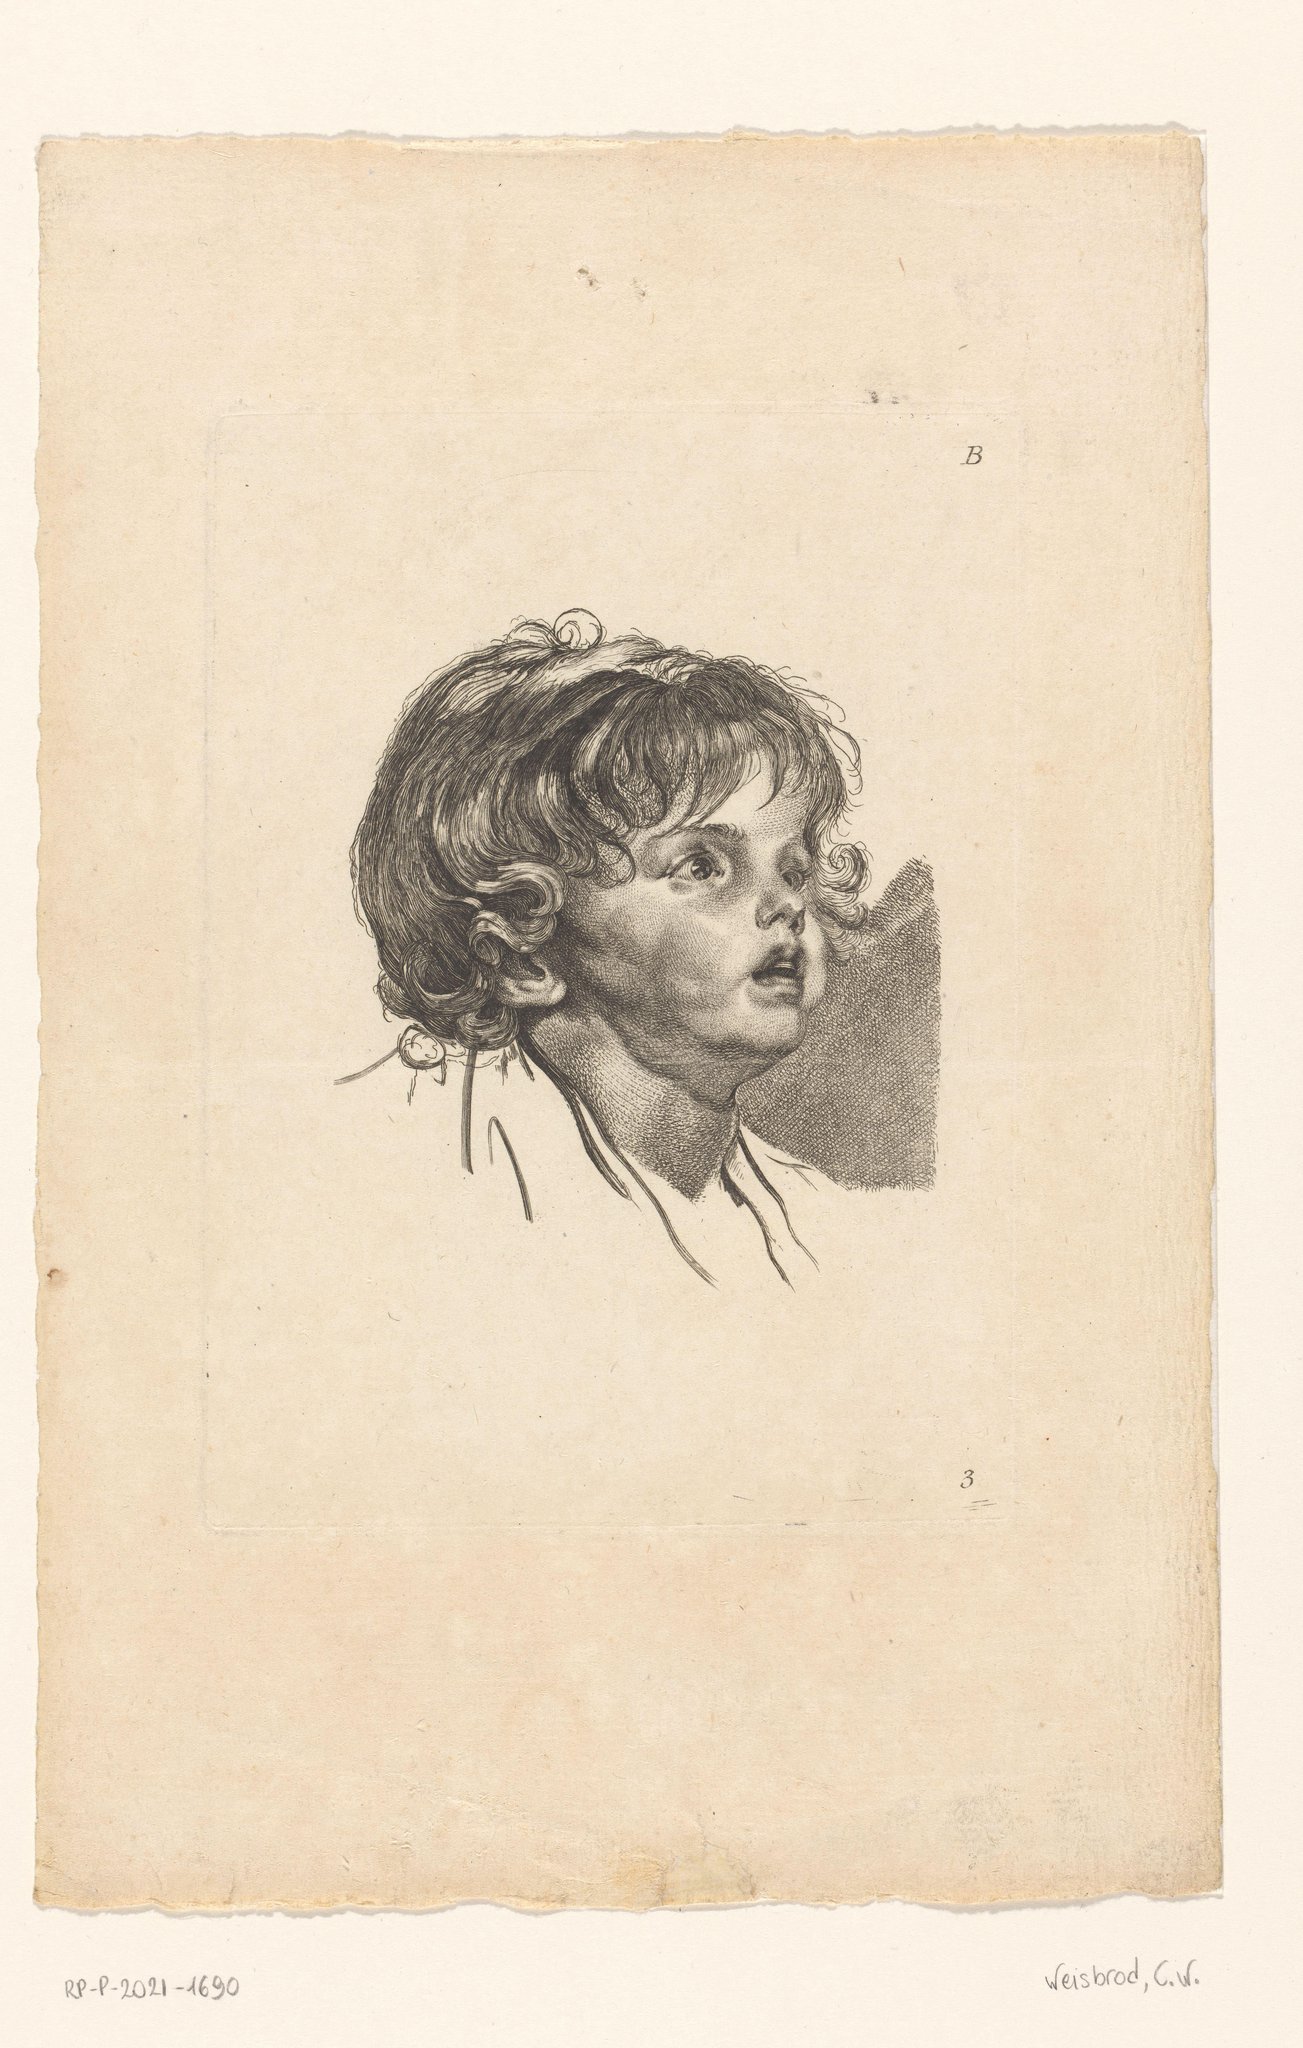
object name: print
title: IIe. Cahier de Têtes de différens Caracteres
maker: carl wilhelm weisbrod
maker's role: print maker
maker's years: 1743-1806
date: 1771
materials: paper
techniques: etching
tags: toddler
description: Rechtsboven: B. Rechtsonder genummerd: 3.